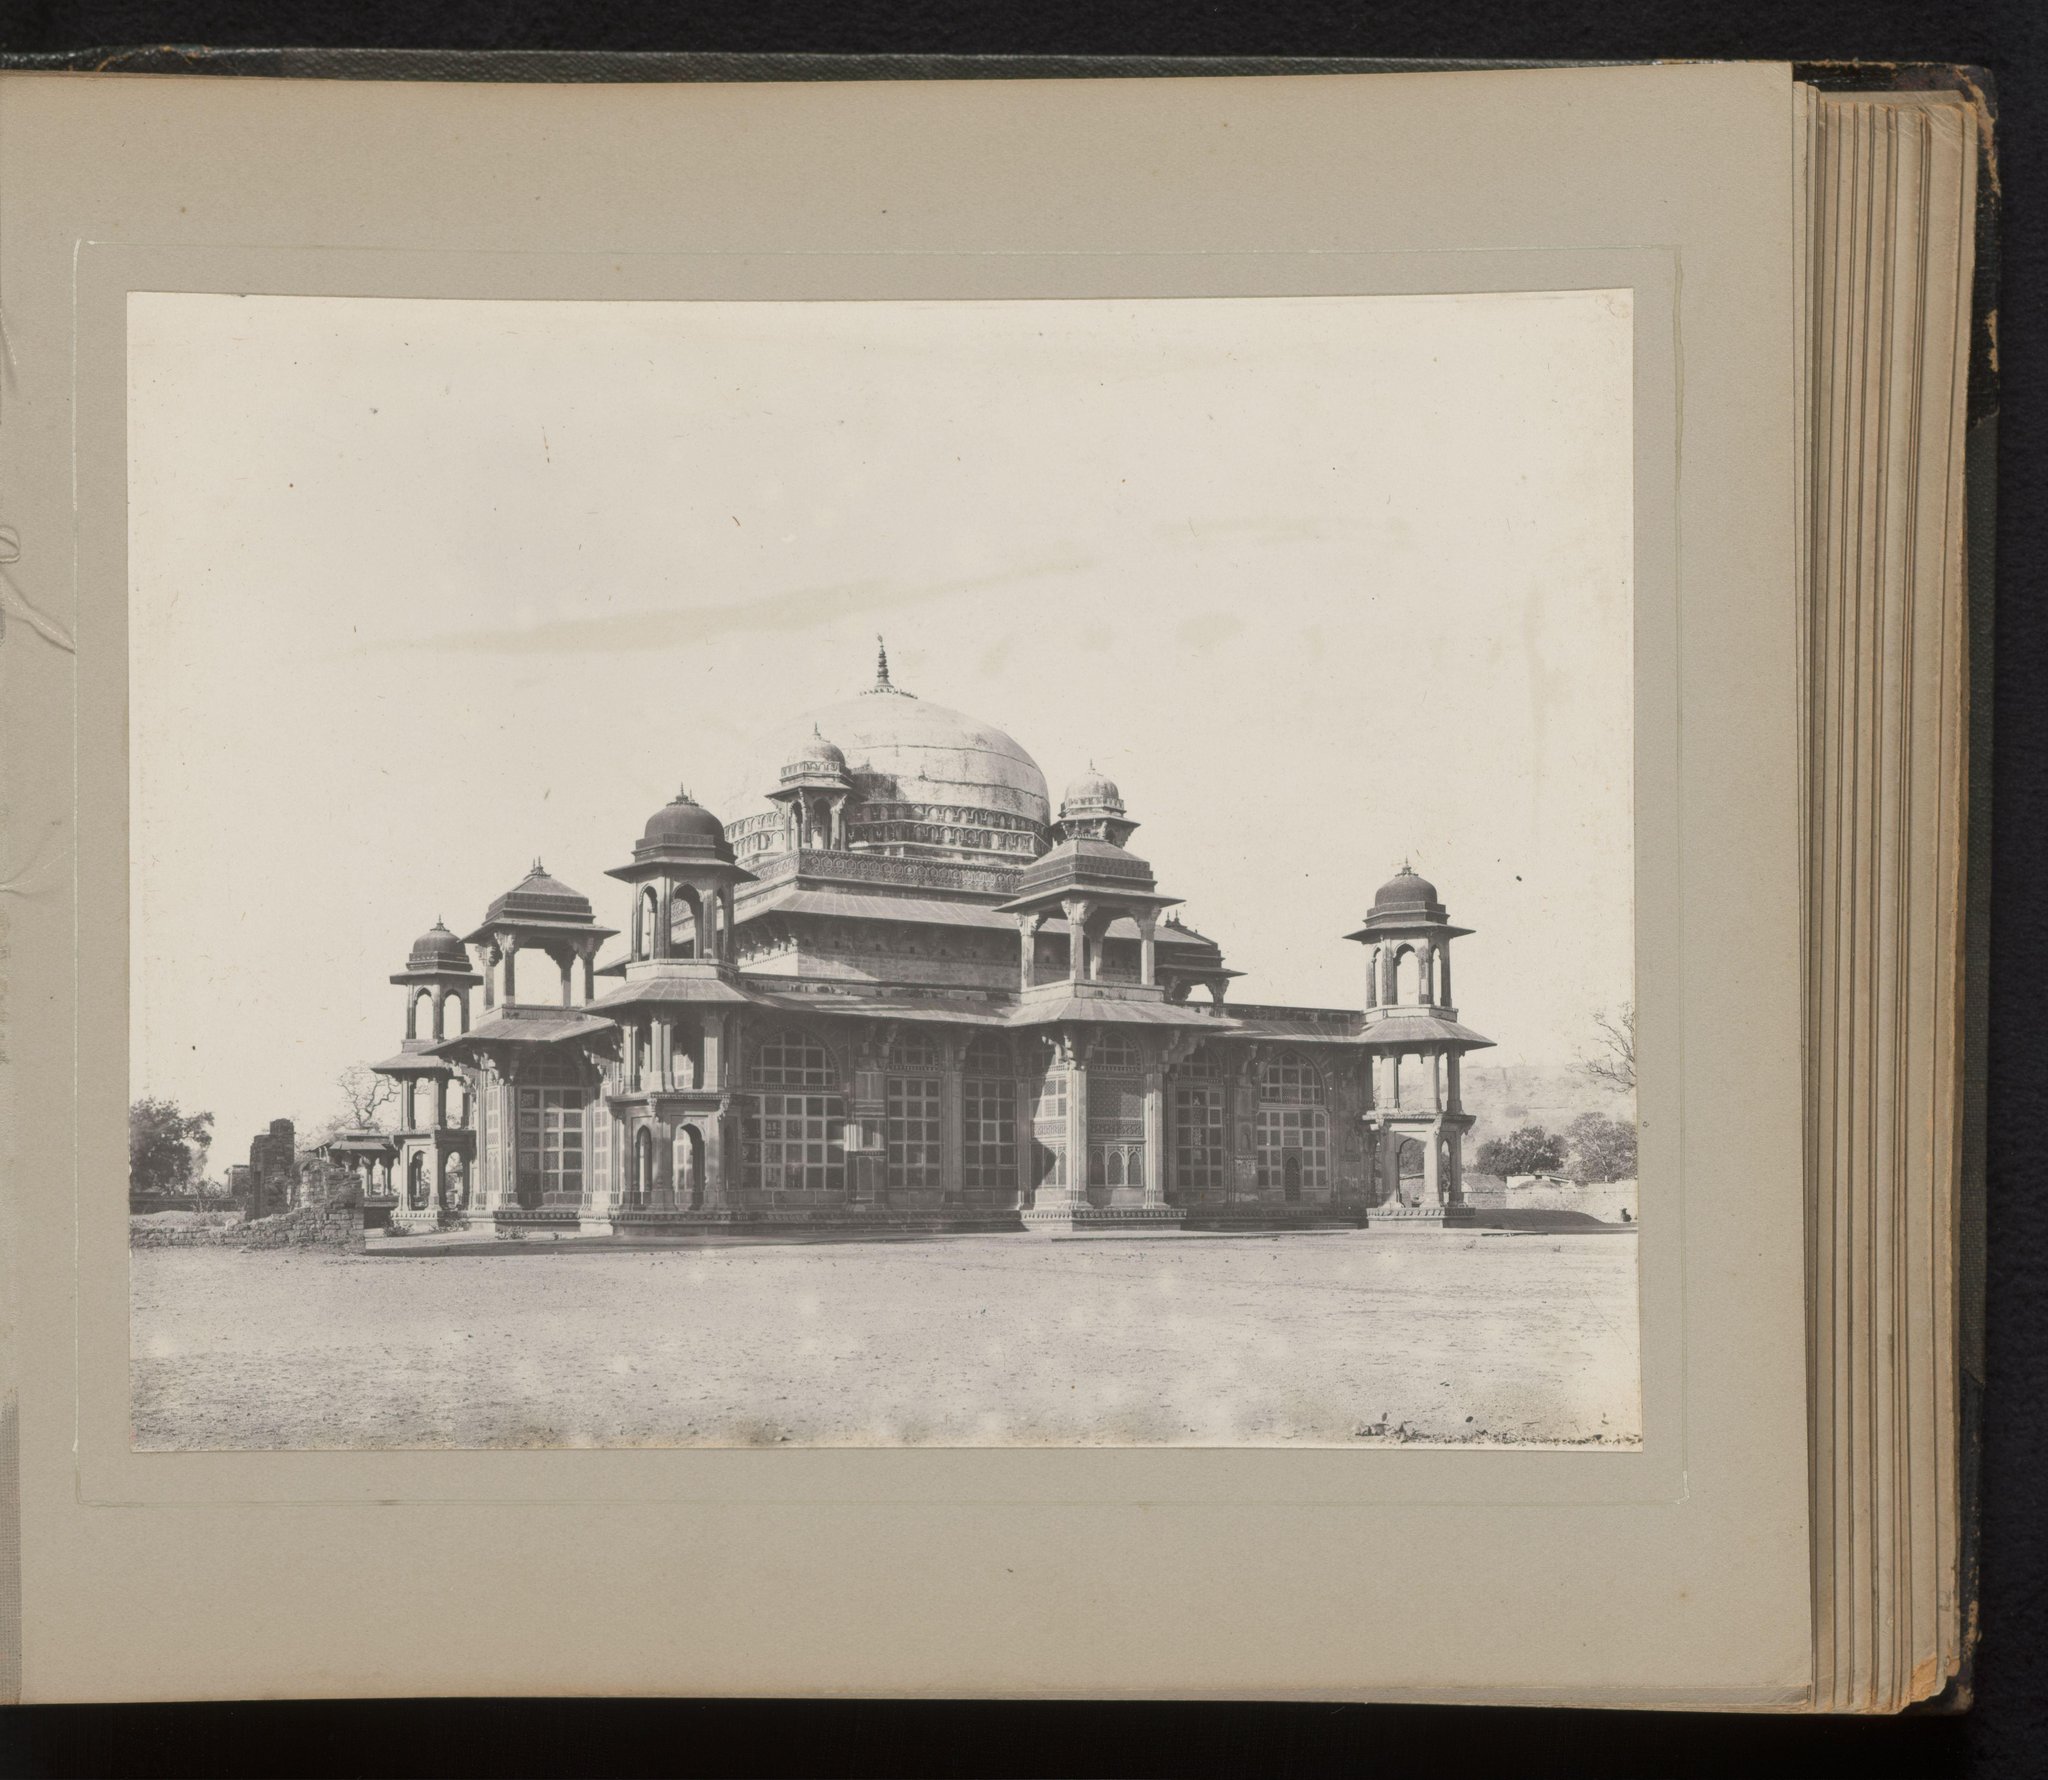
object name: page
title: Tombe van Muhammad Ghawth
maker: k.h. mawal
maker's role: fotograaf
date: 1900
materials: photographic support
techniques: gelatin silver print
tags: musician, landscape with ruins